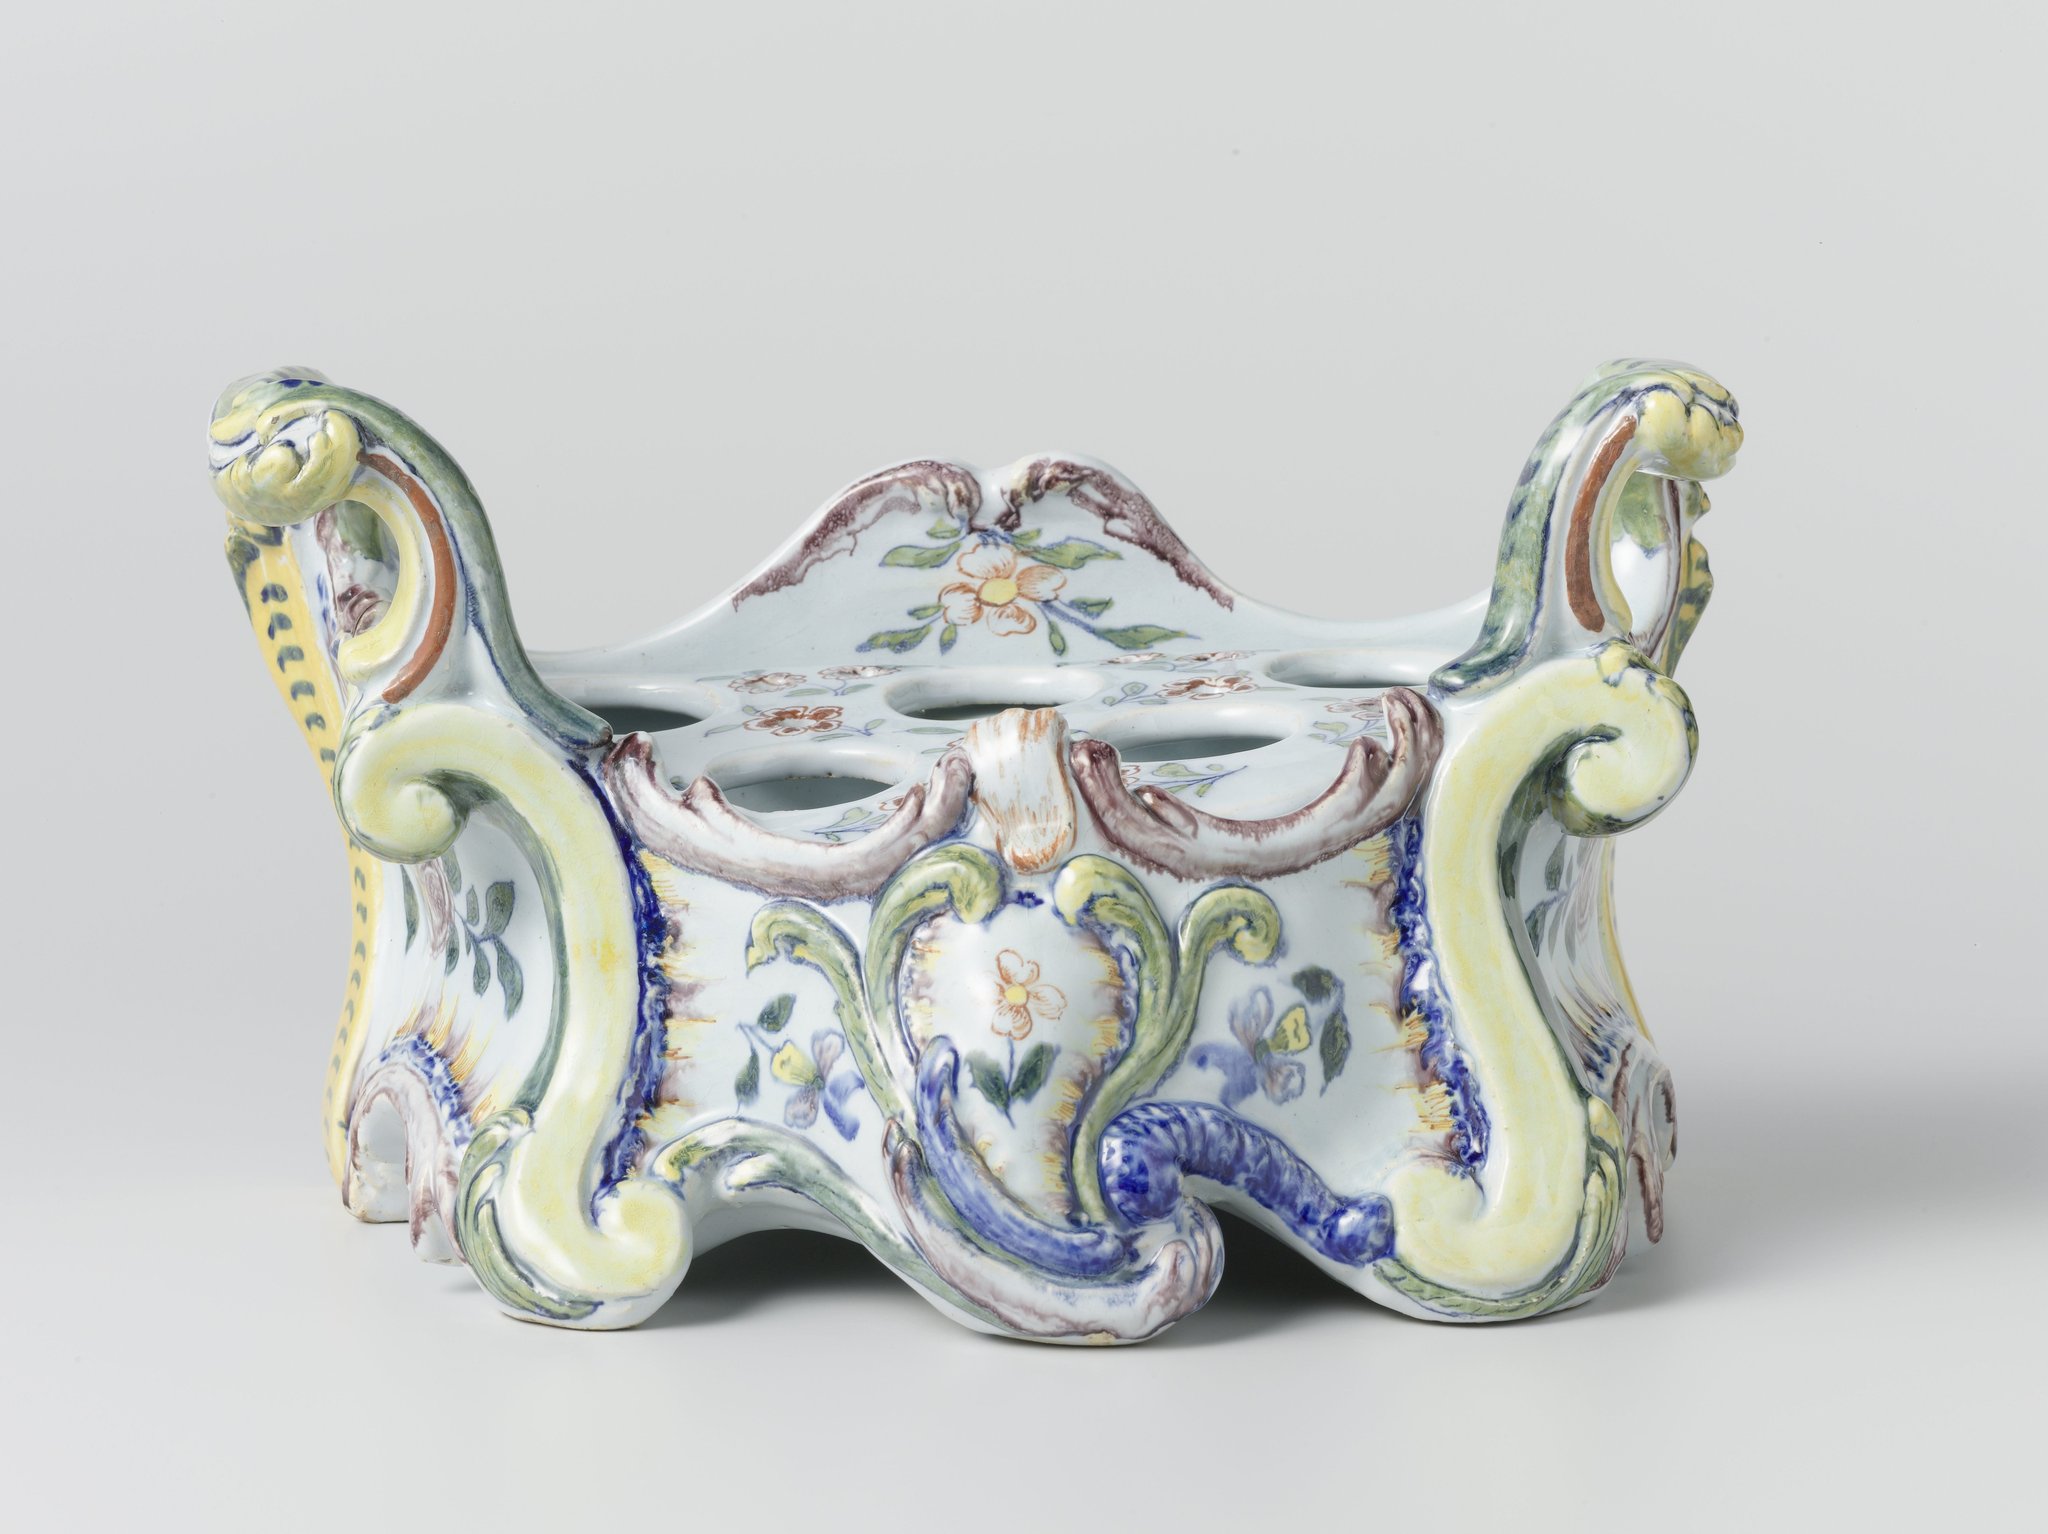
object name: bloemhouder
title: bloemhouder van faïence, veelkleurig beschilderd met strooibloemen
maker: hendrik van hoorn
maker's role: eigenaar plateelbakkerij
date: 1770-1780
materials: faience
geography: delft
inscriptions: mark: ‘HVH / 2’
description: bloemhouder van faïence. Veelkleurig beschilderd met strooibloemen. Met bijbehorende geperforeerde plaat.